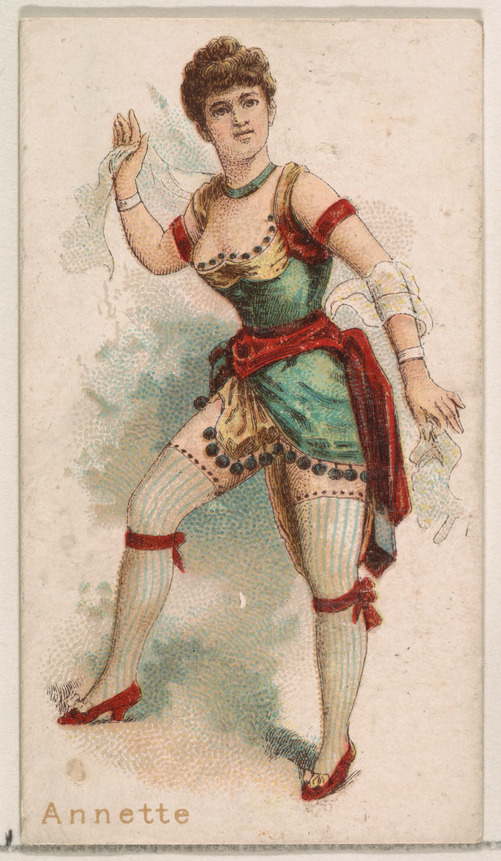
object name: print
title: Annette, from the Ballet Queens series (N182) issued by Wm. S. Kimball & Co.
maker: william s. kimball & company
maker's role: publisher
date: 1889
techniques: color lithograph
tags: women